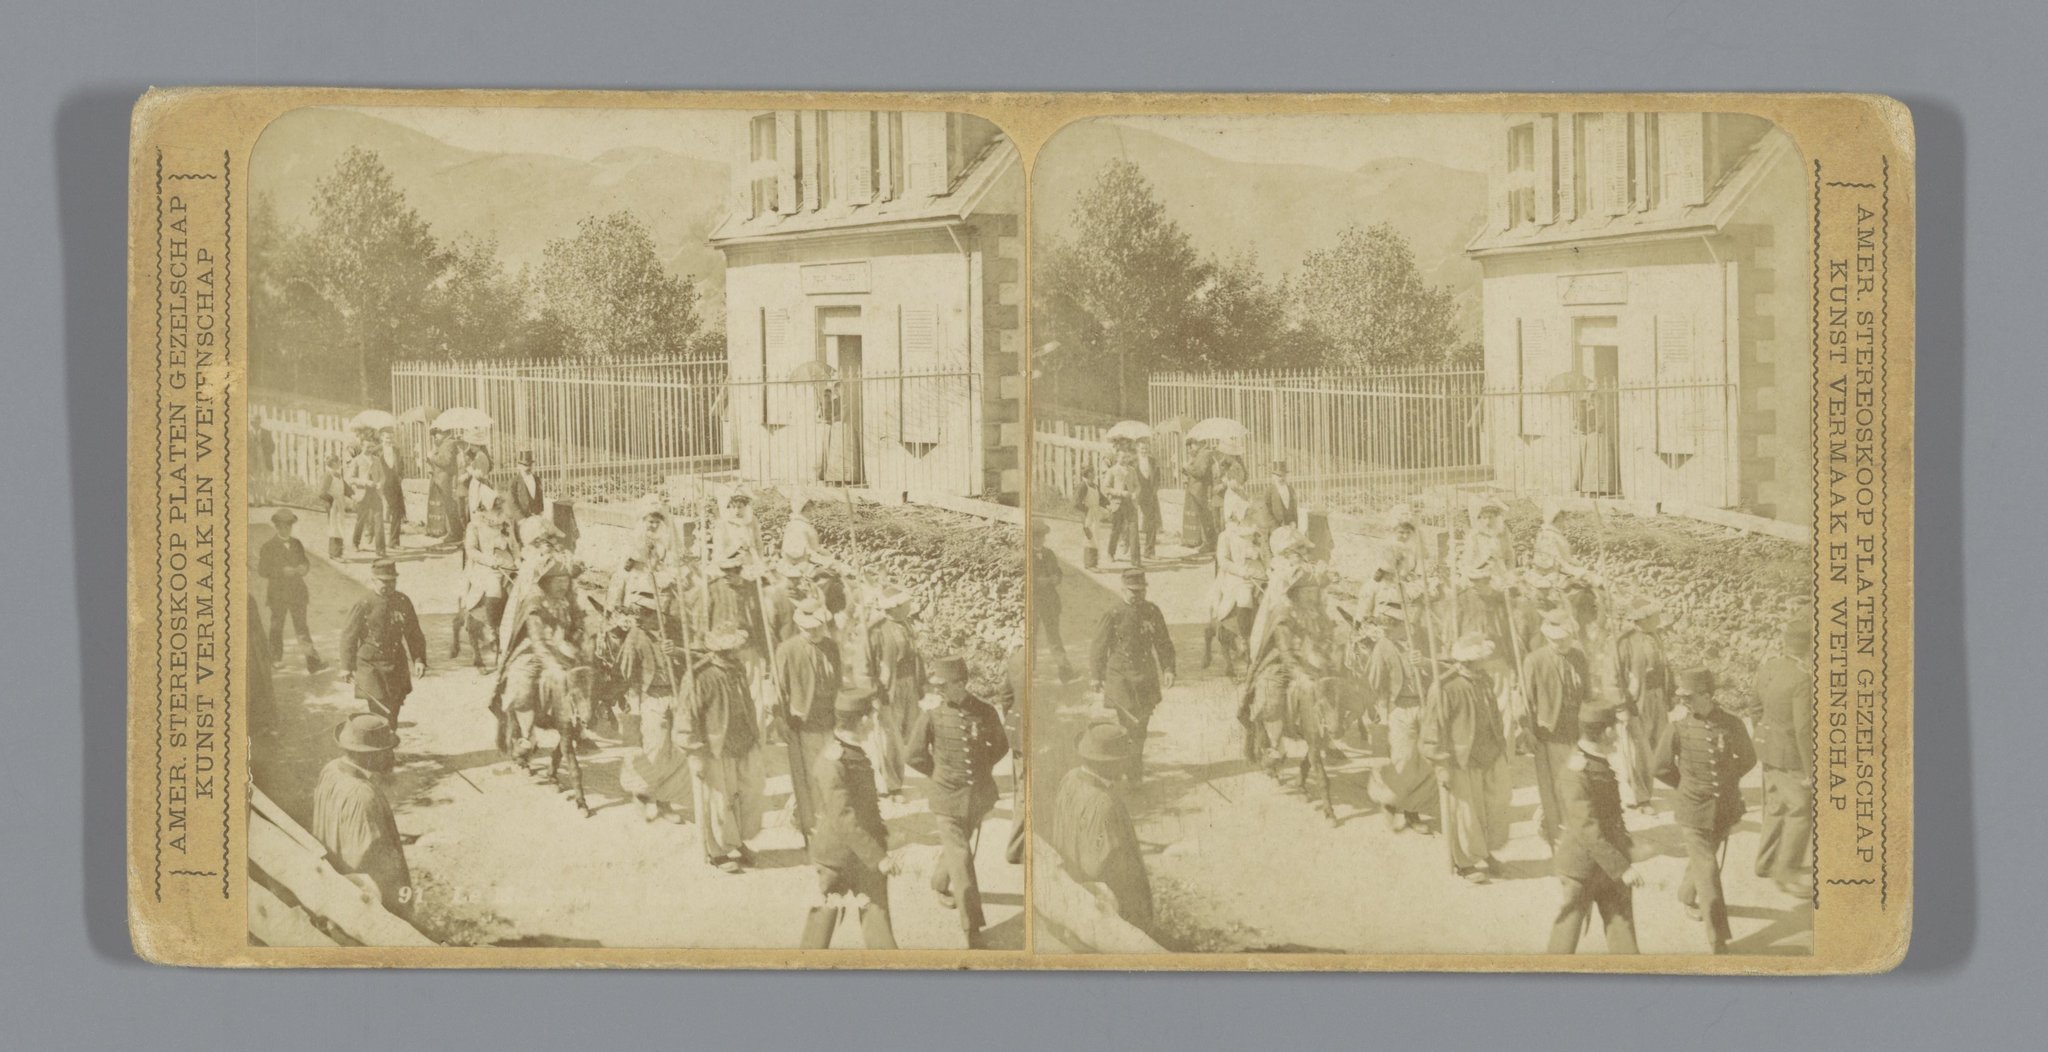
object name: stereograph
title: Gezicht op een straat (vermoedelijk) te Frankrijk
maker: Anonymous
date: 1860-1880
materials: cardboard, photographic support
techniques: albumen print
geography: france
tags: street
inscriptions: number: ‘281’, inscription: ‘Rodr[...] 46’